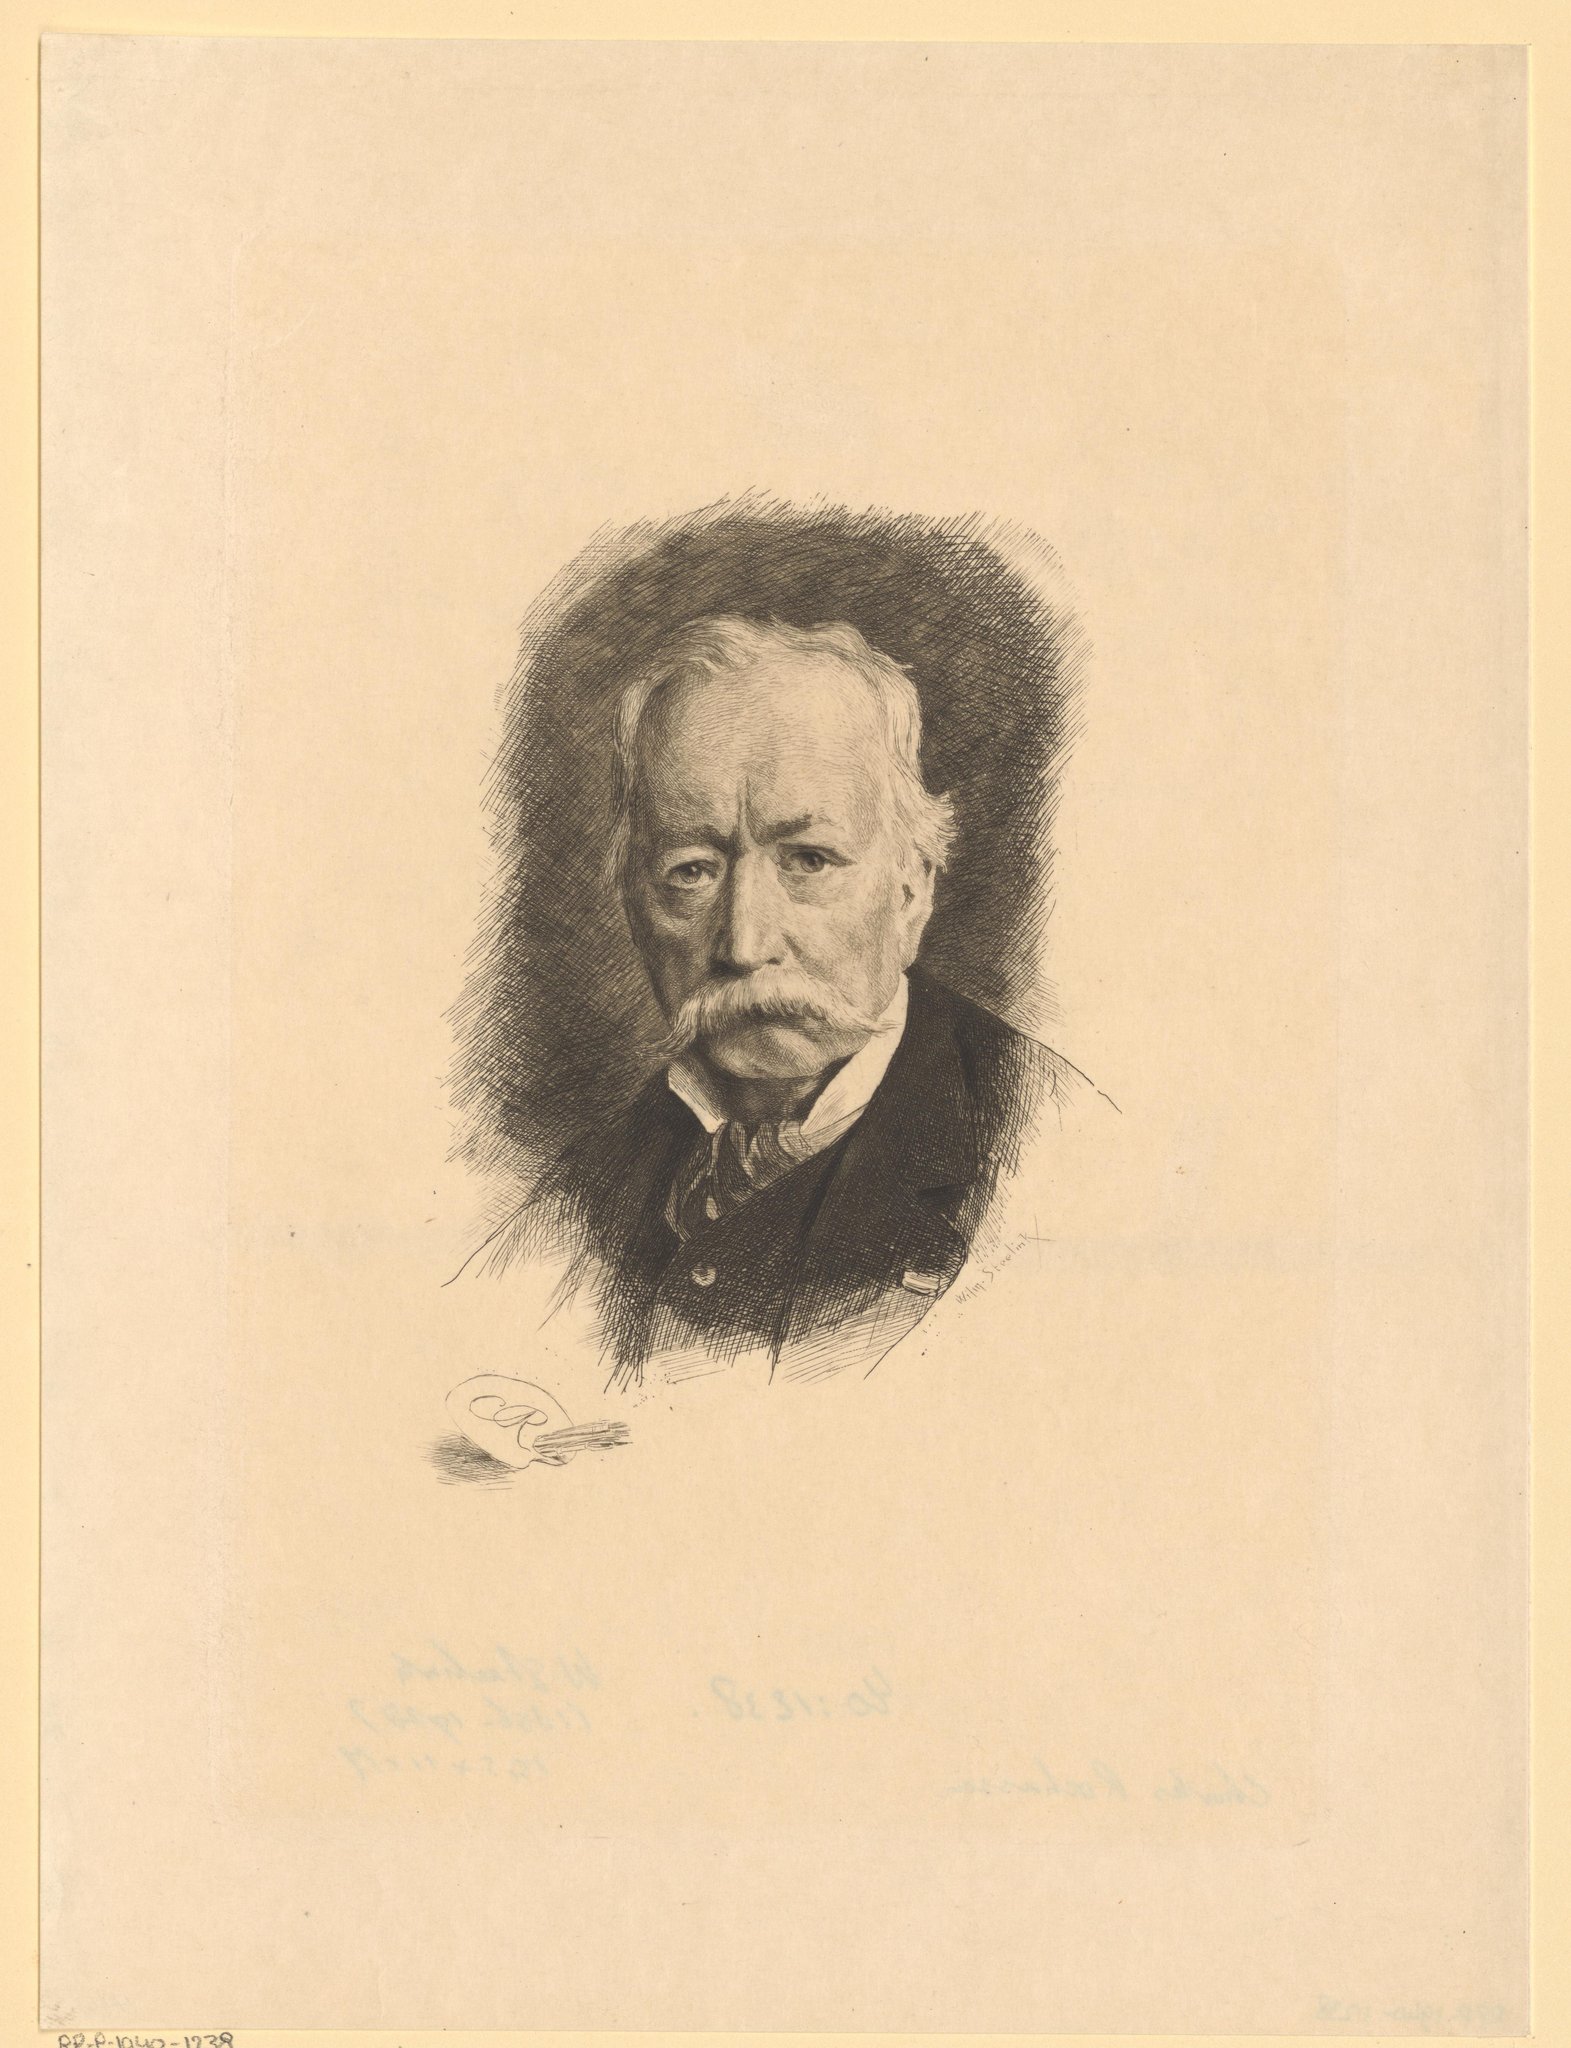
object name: print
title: Portret van Charles Rochussen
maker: willem steelink (ii)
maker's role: draughtsman, print maker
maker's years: 1856-1928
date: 1866-1928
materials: paper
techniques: etching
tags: painter, draughtsman, charles rochussen, moustache, historical persons, portrait, self-portrait of painter, palette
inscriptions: collector's mark: Lugt 2760, collector's mark: Lugt 2228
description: Onder het portret zijn initialen op een schilderspalet.